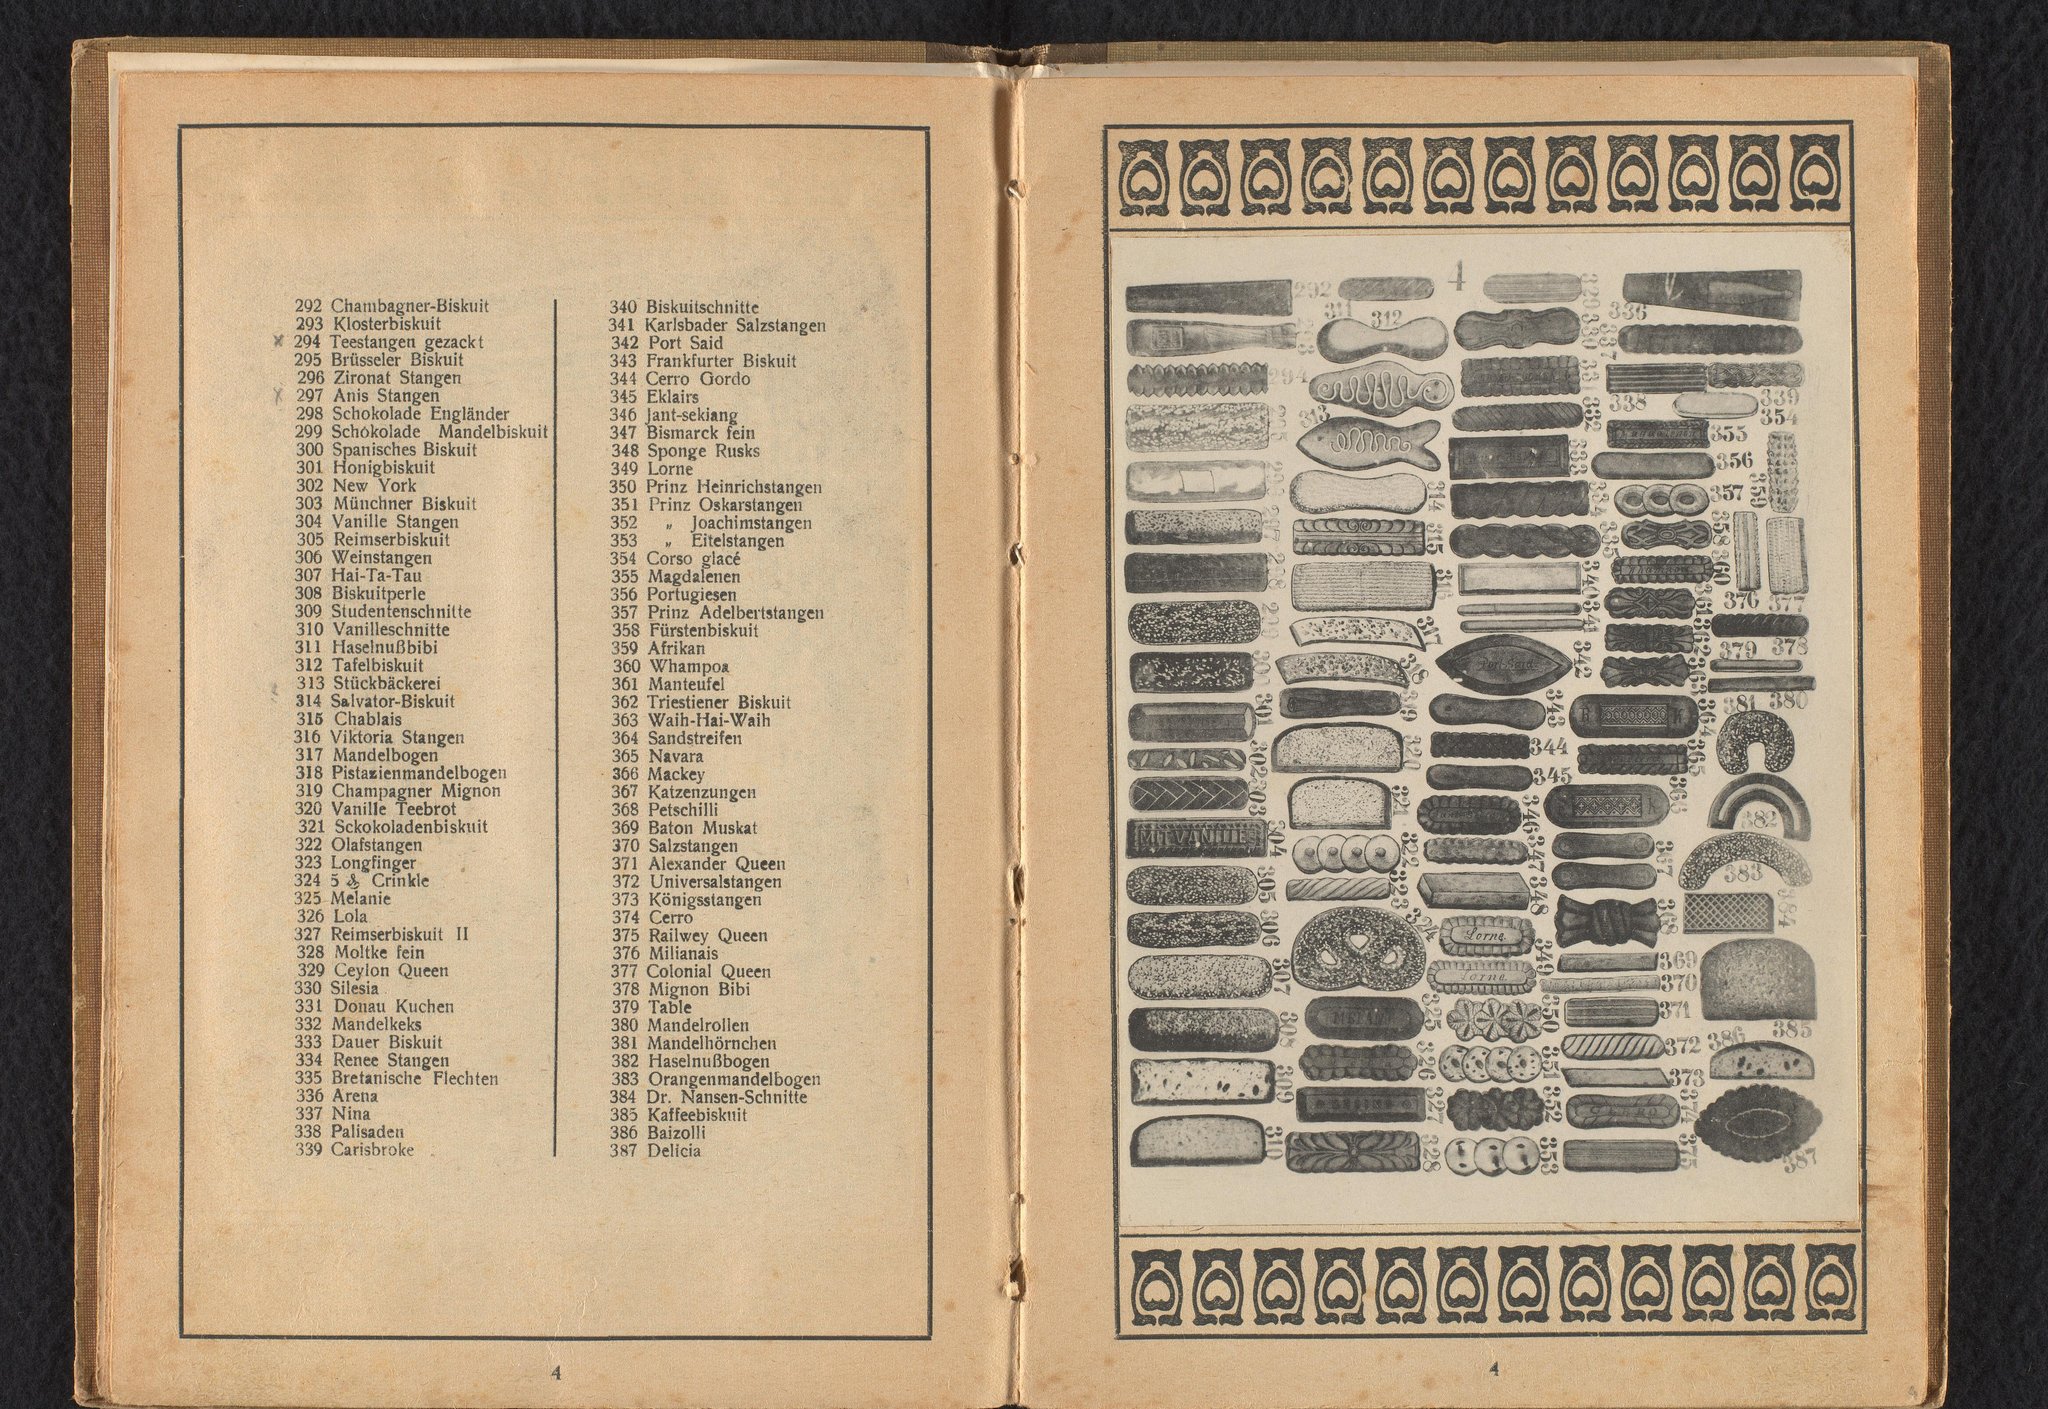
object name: page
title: Verschillende Engelse koekjes en biscuits als voorbeeld bij recepten 292-387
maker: Anonymous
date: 1900-1905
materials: paper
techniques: photograph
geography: bad langensalza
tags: pastry cook, moulds for biscuits, biscuits